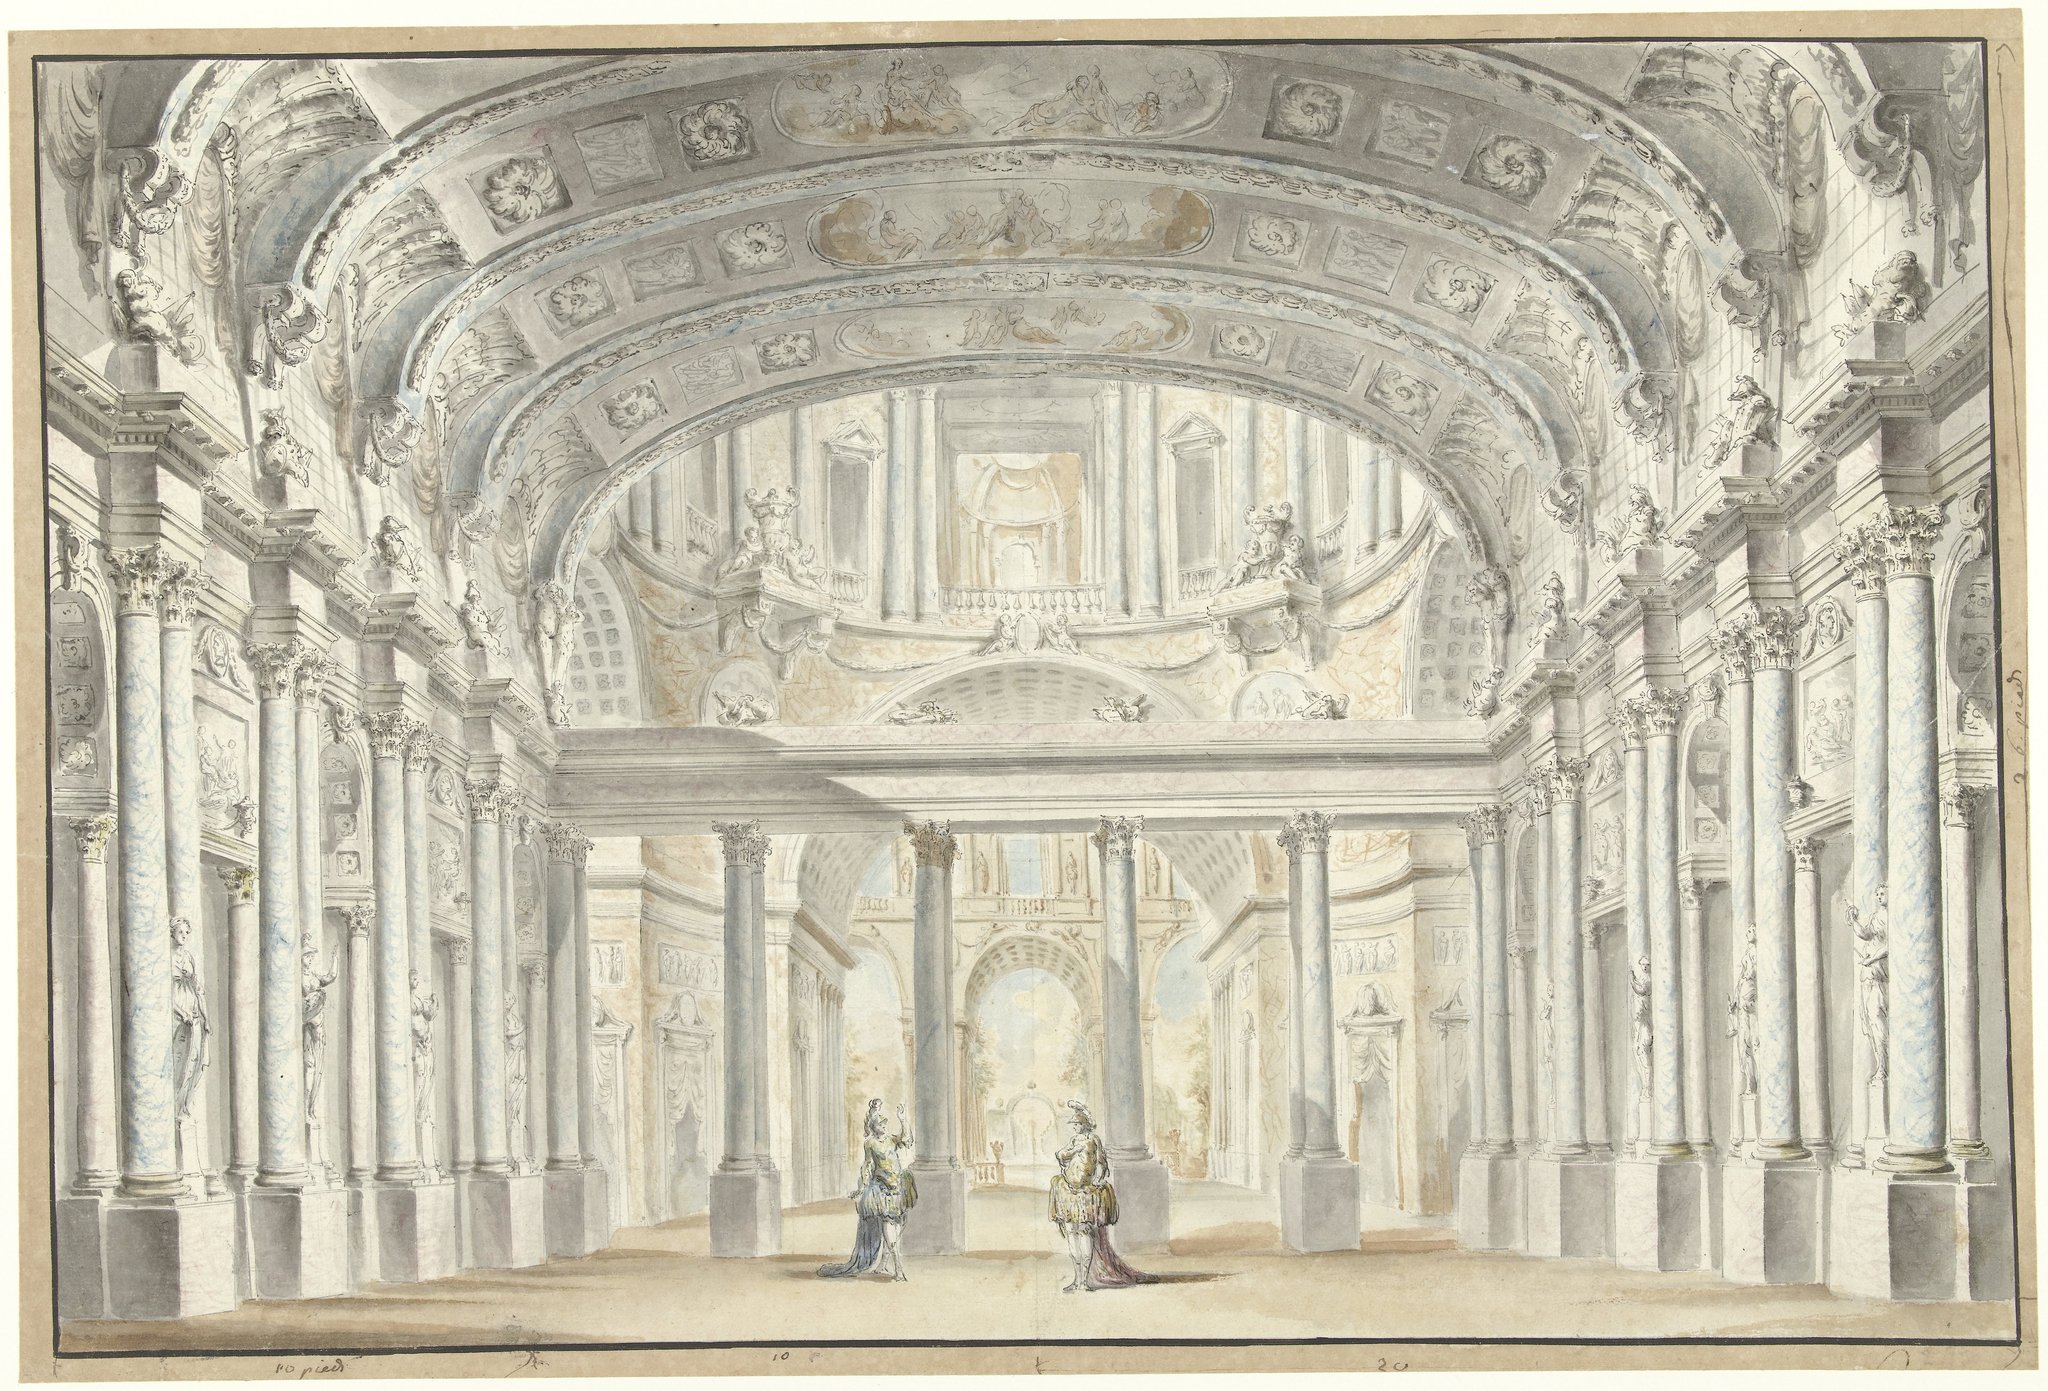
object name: design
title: De Hofzaal, toneeldecor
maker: georges françois blondel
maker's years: 1730-1792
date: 1763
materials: ink, paper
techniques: brush, pen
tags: palace - aa - civic architecture: inside, stage design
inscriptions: inscription, recto, underneath the drawing, pen and black ink: ‘10 pieds / 10 / 20’, collector's mark, verso, lower centre: Lugt 2228, annotation, recto, lower, pencil: ‘Blondel decor[?]ier Pour Le [S]cobu[nrgn?] asterdame 1763’, inscription, recto, in the right margin:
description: Toneelontwerp voor de Amsterdamse Stadschouwburg.